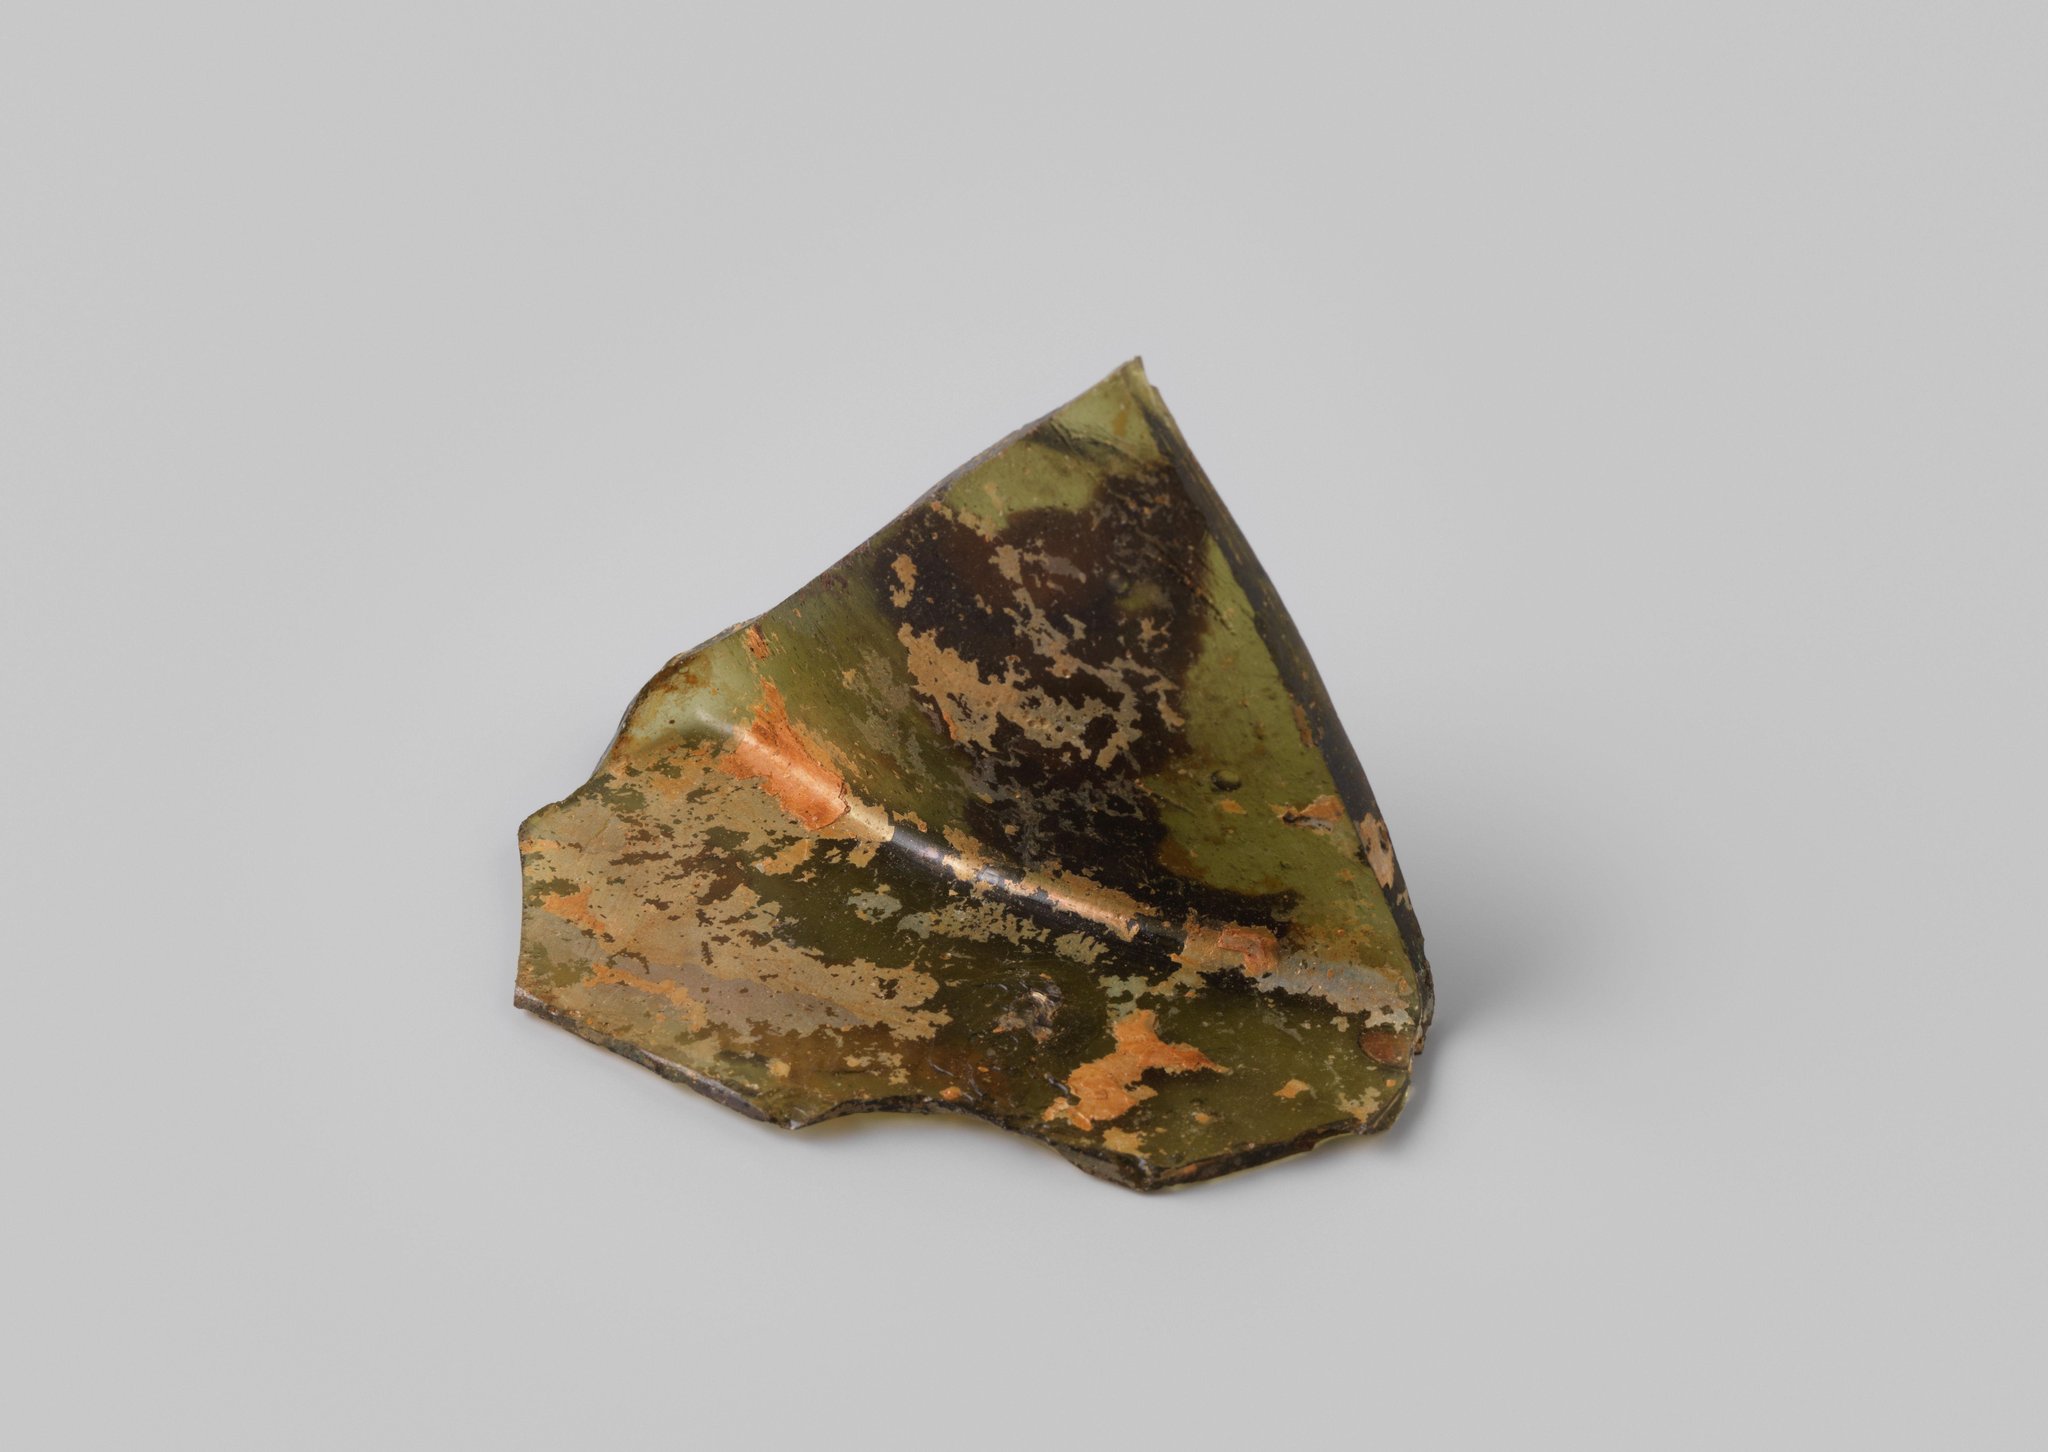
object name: sherd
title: Scherf van een kelderfles uit het wrak van de Oost-Indiëvaarder Hollandia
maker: Anonymous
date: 1700-1743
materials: glass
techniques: green glass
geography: netherlands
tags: verenigde oostindische compagnie, hollandia (schip), annet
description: Case bottle, fragm of base, straight sided, shallow kick-up, hollow pontil mark.